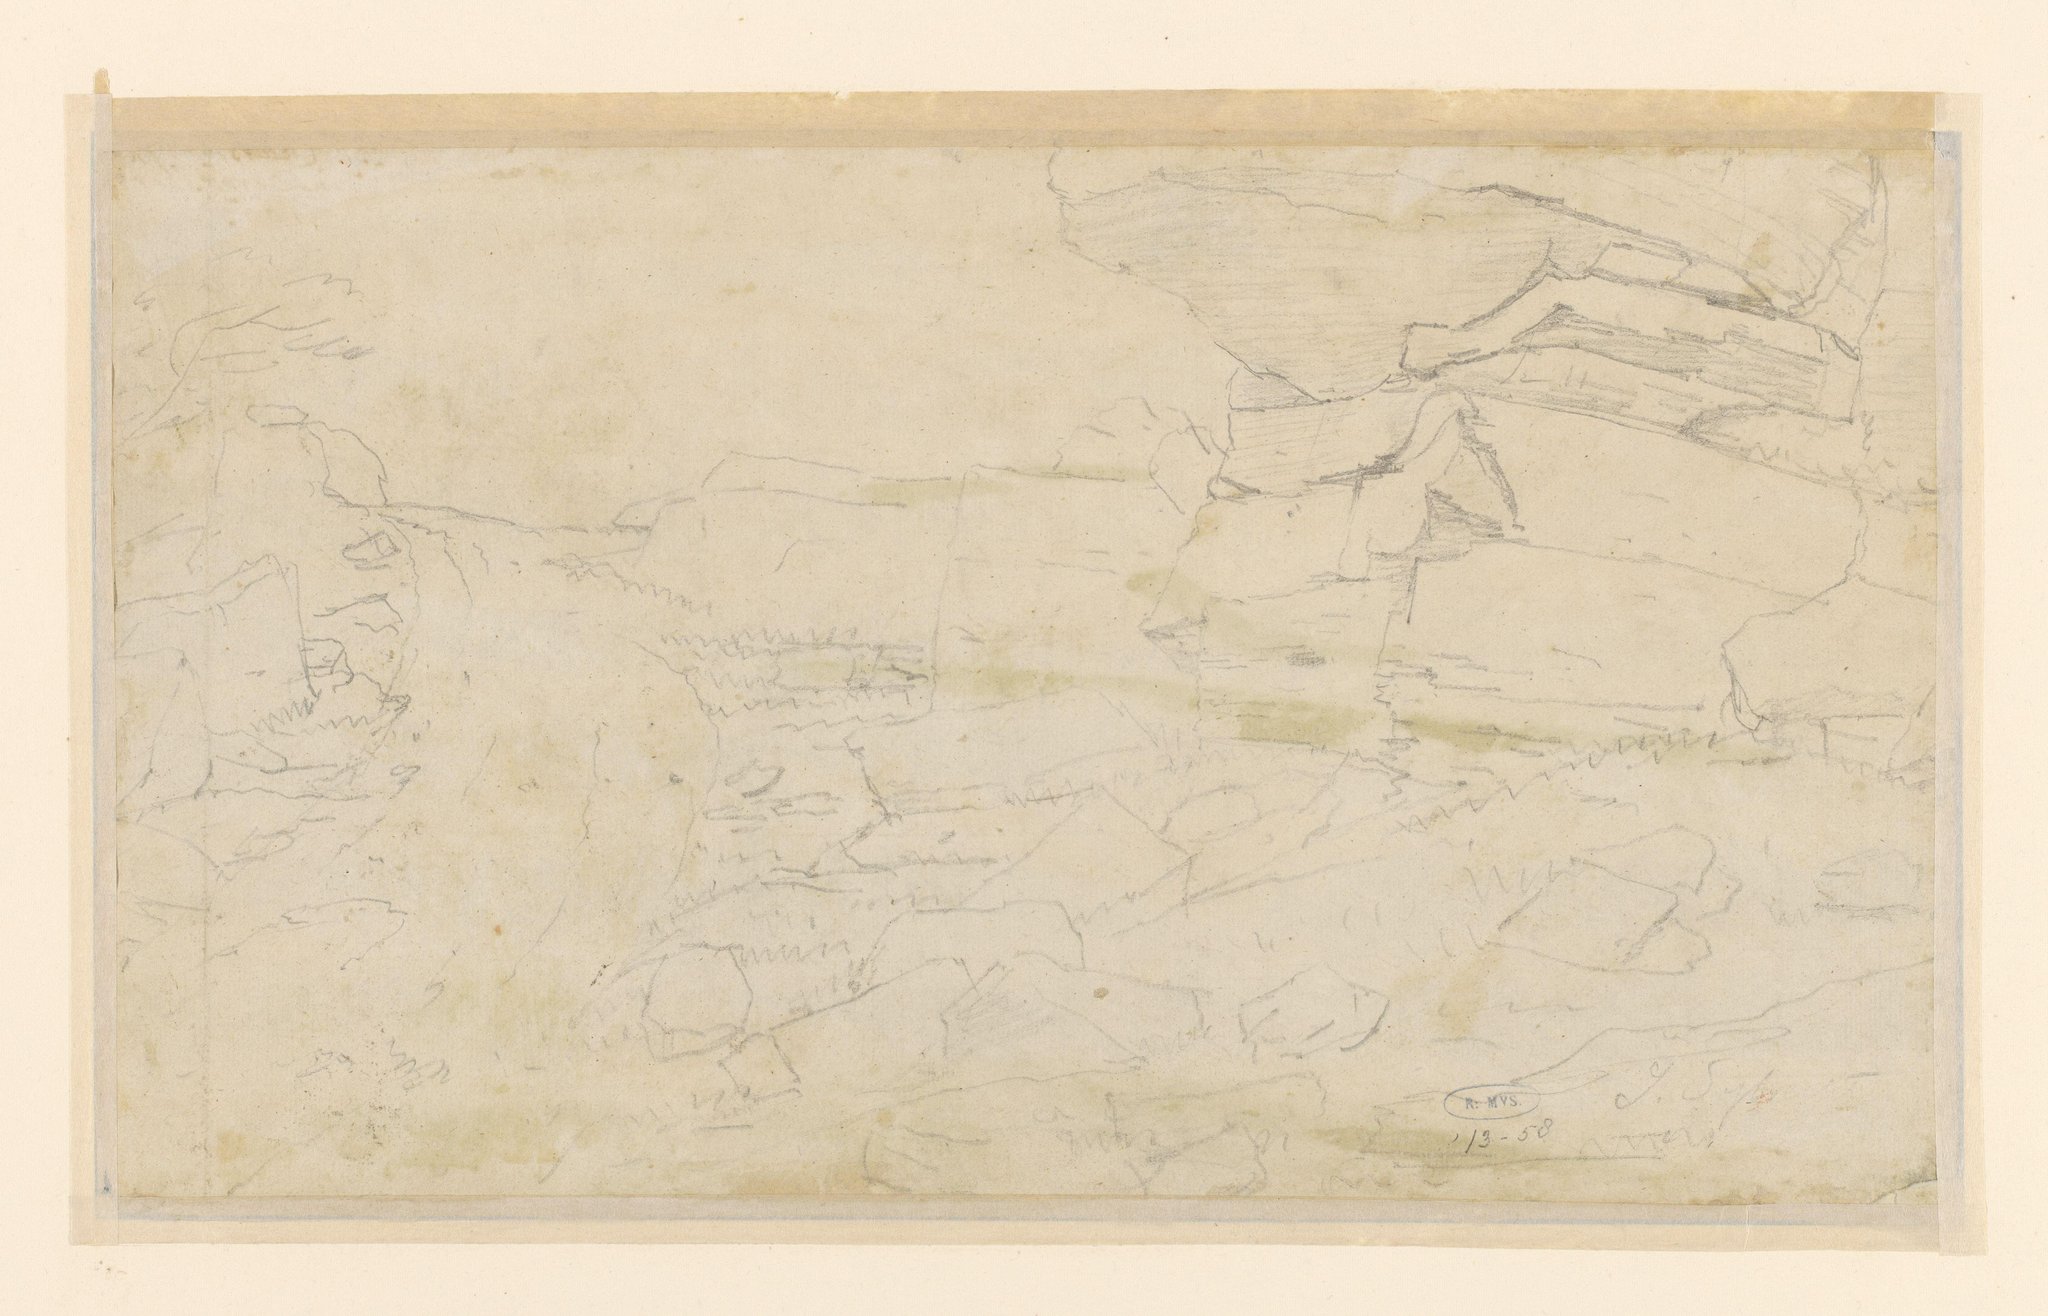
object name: drawing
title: Schets van rotsen langs een weg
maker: jan siberechts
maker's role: draughtsman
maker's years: 1627-1703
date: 1694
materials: chalk, paper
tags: rock-formations, united kingdom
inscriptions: date